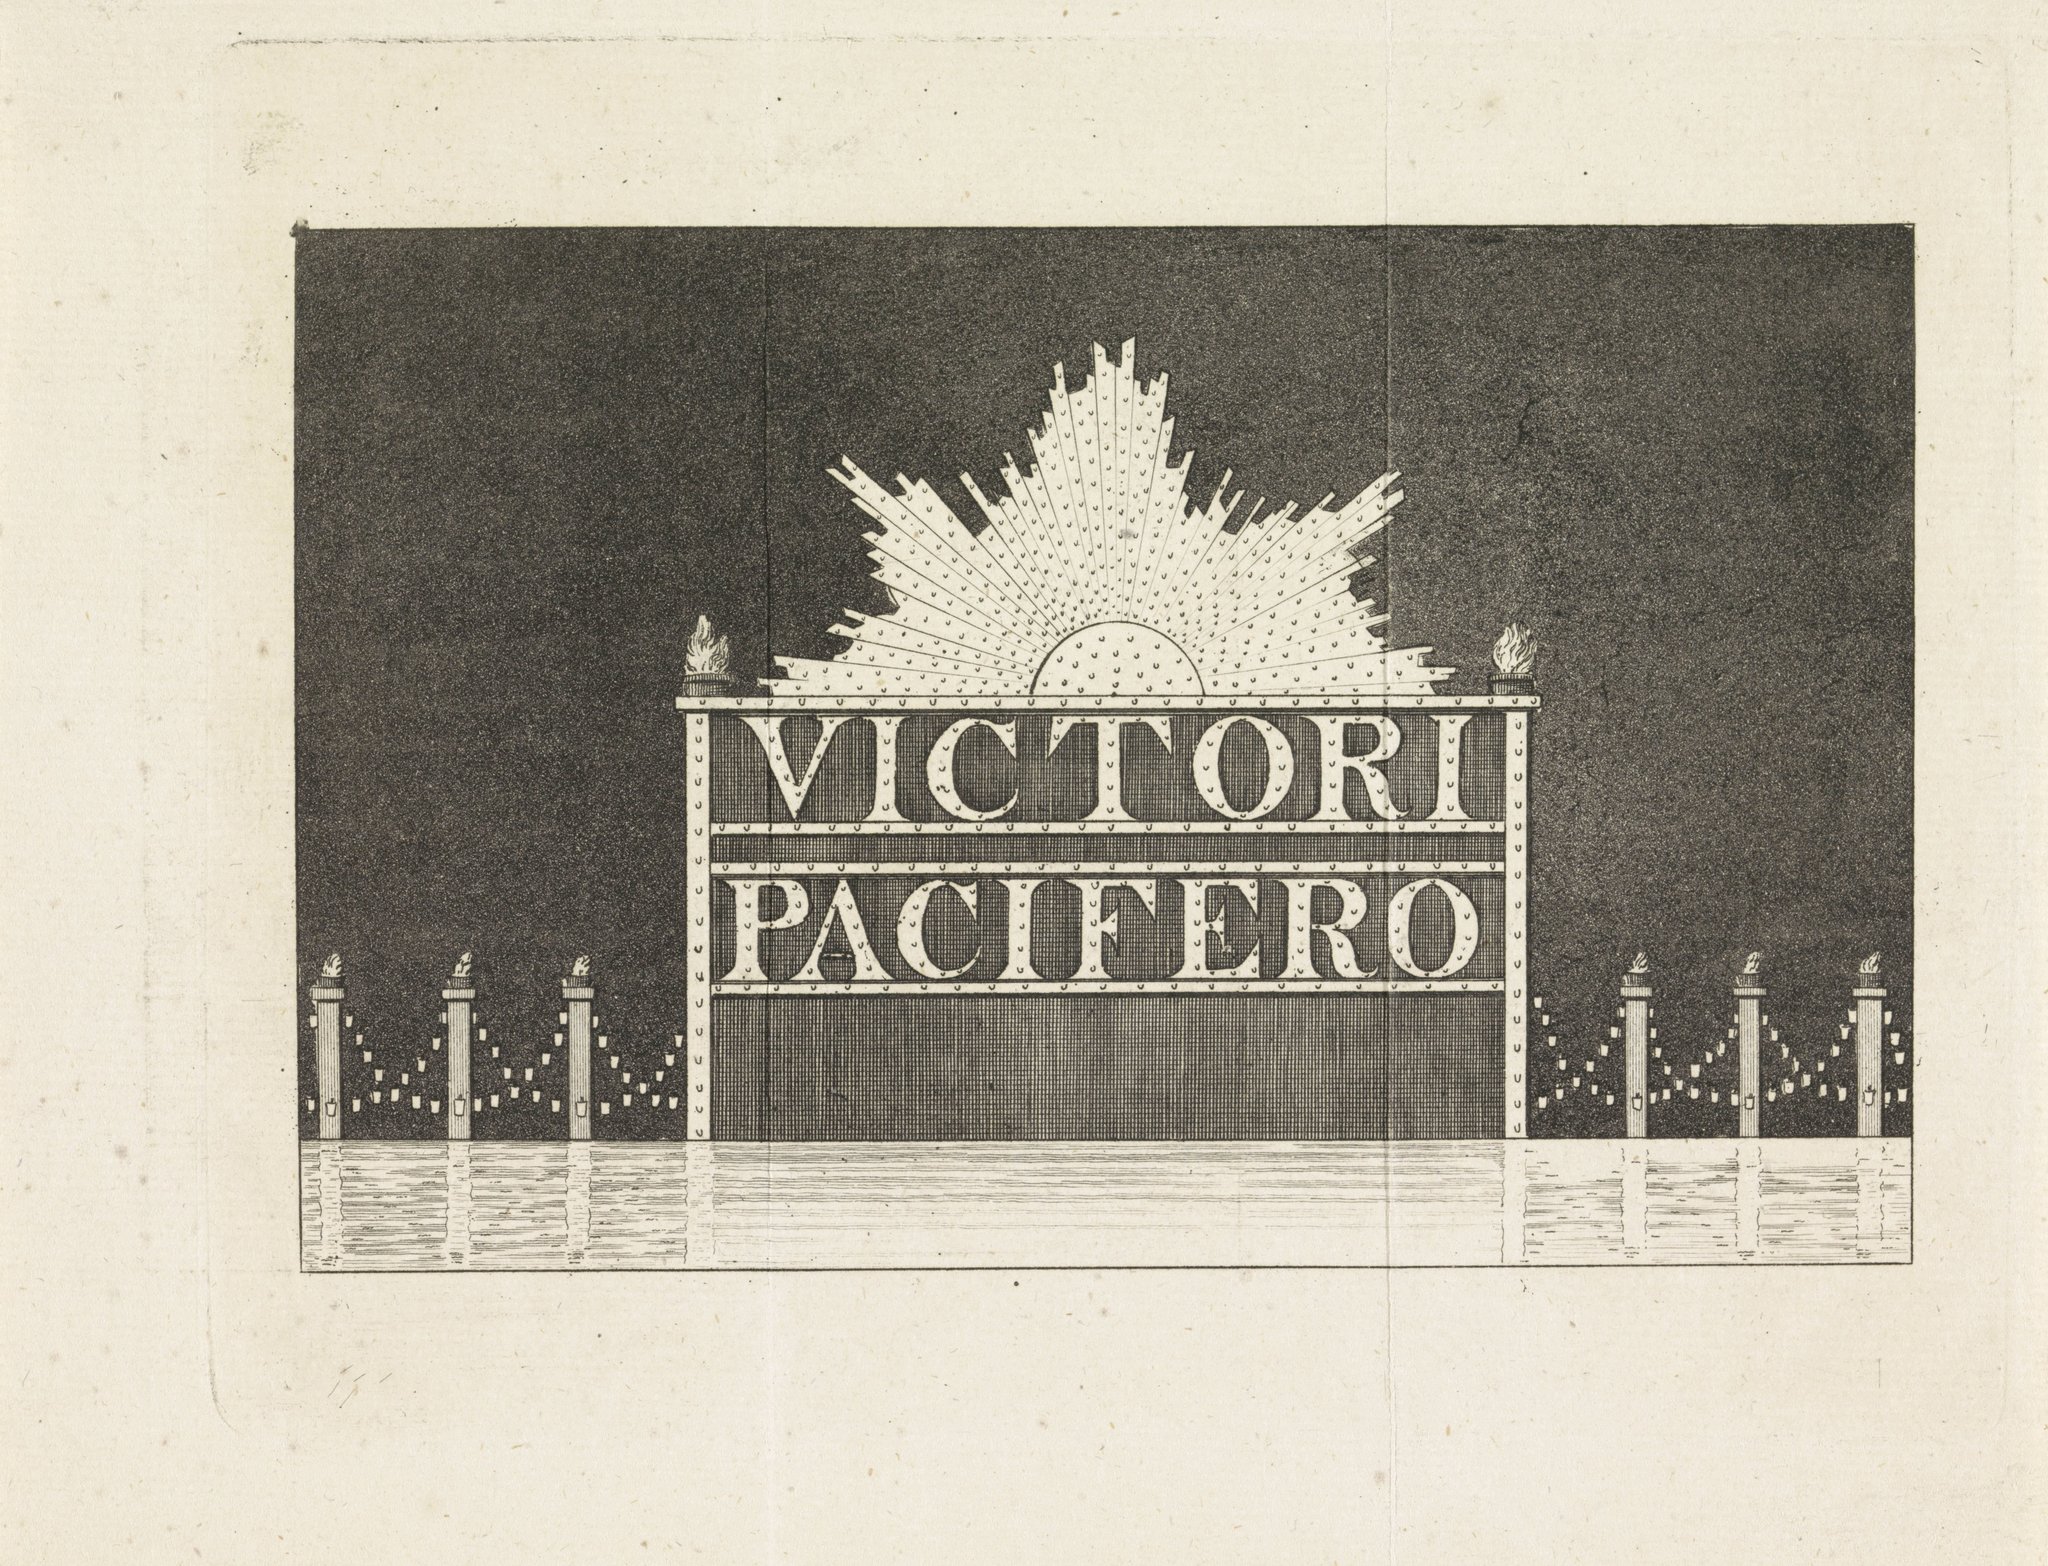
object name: print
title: Illuminatie, 1816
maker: antoni zürcher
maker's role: print maker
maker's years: 1754-1837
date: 1816-1817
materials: paper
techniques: engraving, etching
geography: netherlands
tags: anna paulowna romanowa, william ii of the netherlands, public festivities on the occasion of royal events (+ illumination, fire-works ~ festive activities), decoration and illumination of streets, squares, etc. (~ triumphal entry, etc.), amsterdam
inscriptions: collector's mark: Lugt 2228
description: Illuminatie met het verlichte opschrift 'Victori Pacifero' op een brug. Illustraties van de decoraties opgesteld bij het bezoek van de prins en prinses van Oranje aan Amsterdam op 19 september 1816.